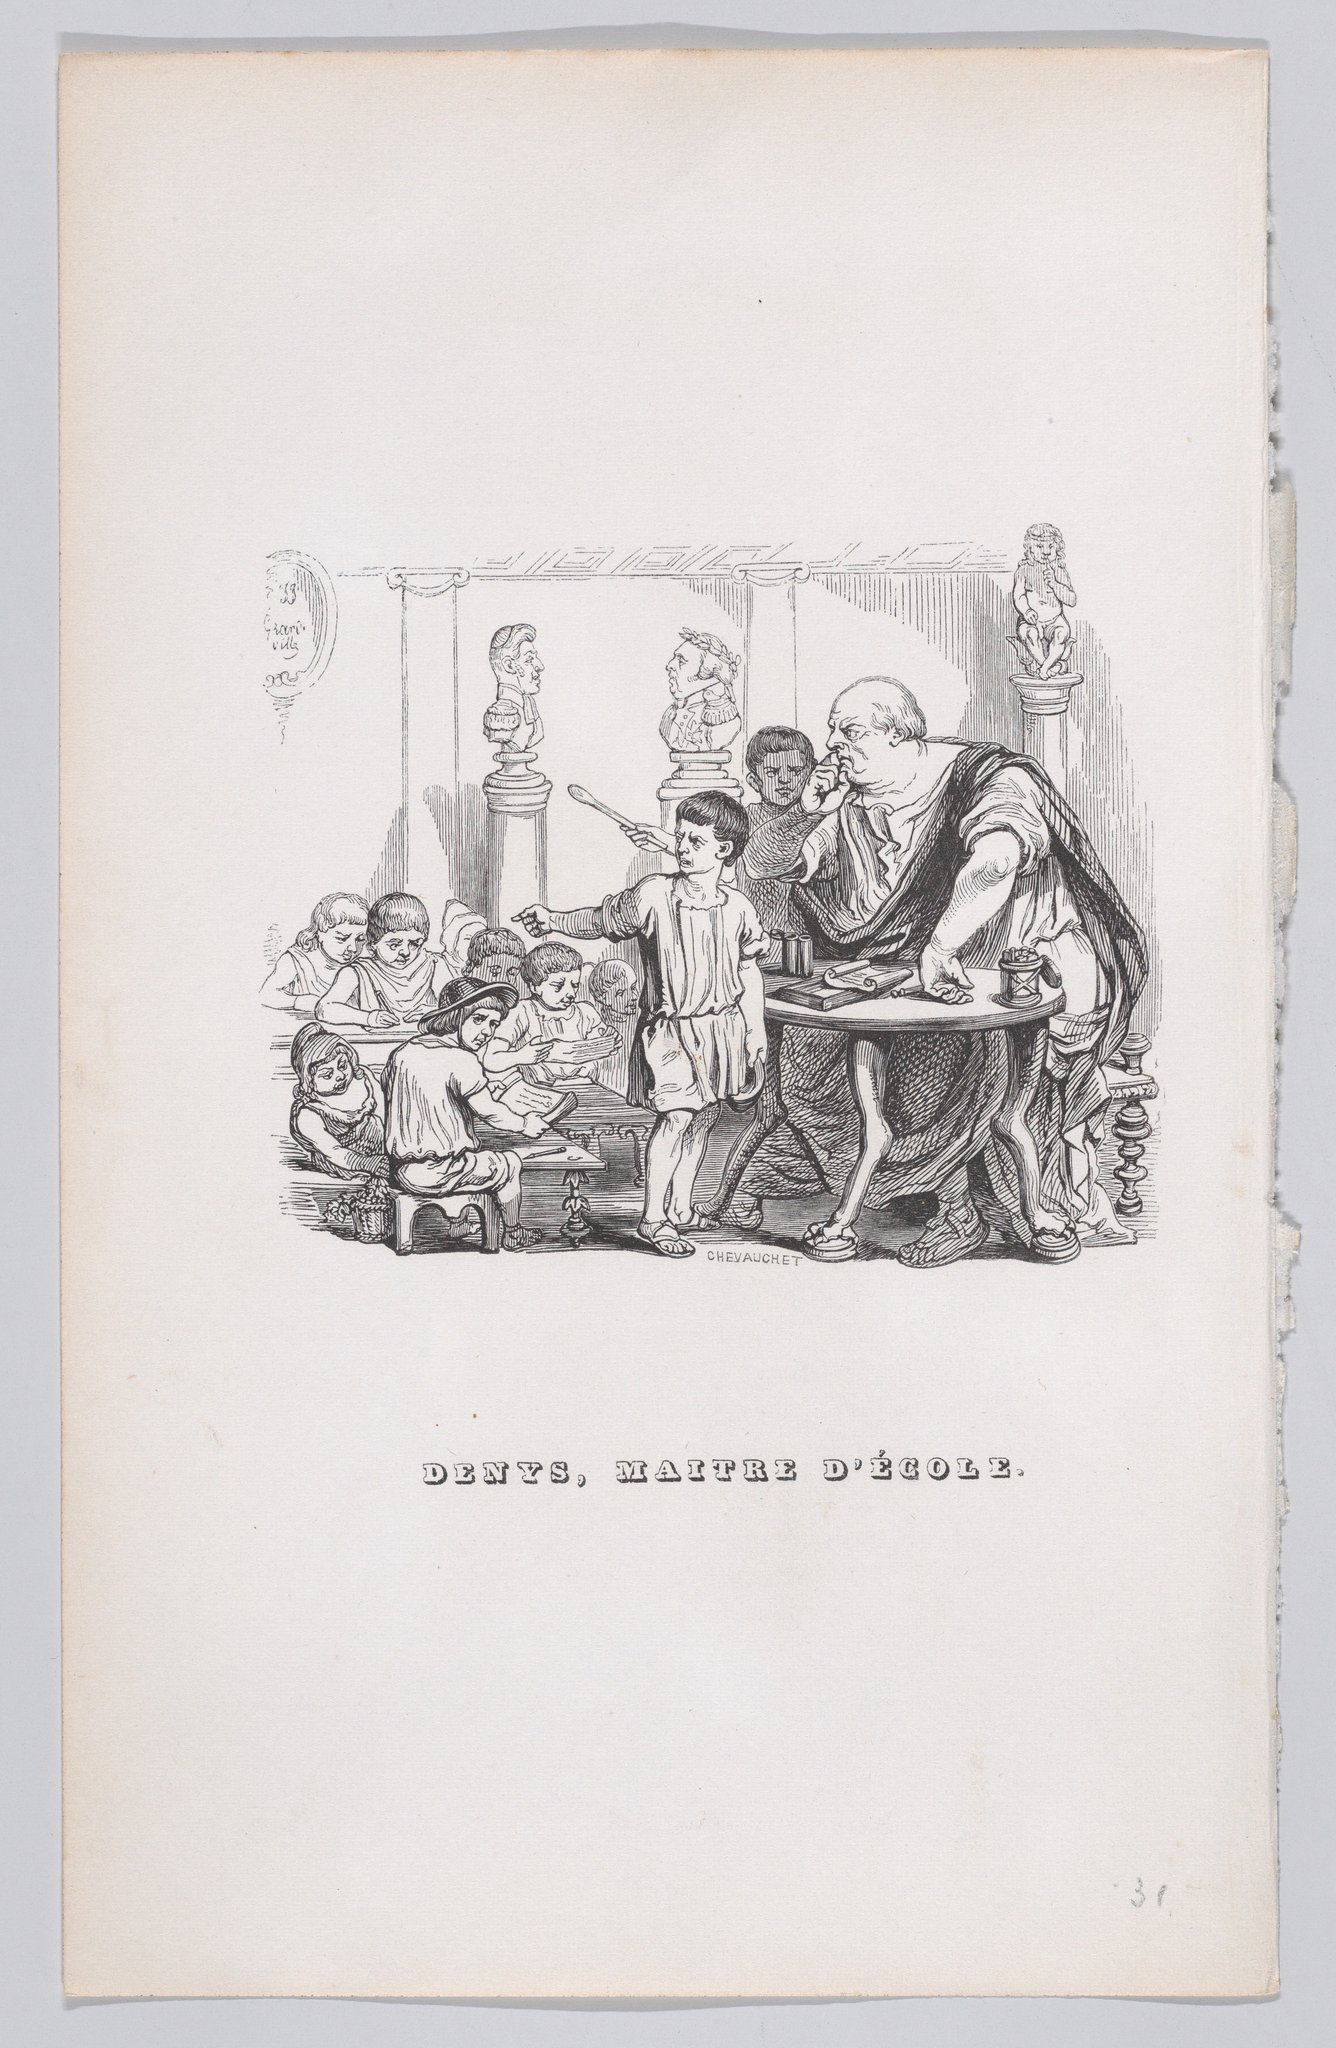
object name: print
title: Denis, School Master, from "The Complete Works of Béranger"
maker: j. j. grandville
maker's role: illustrator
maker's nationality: french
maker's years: 1803-1847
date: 1836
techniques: engraving